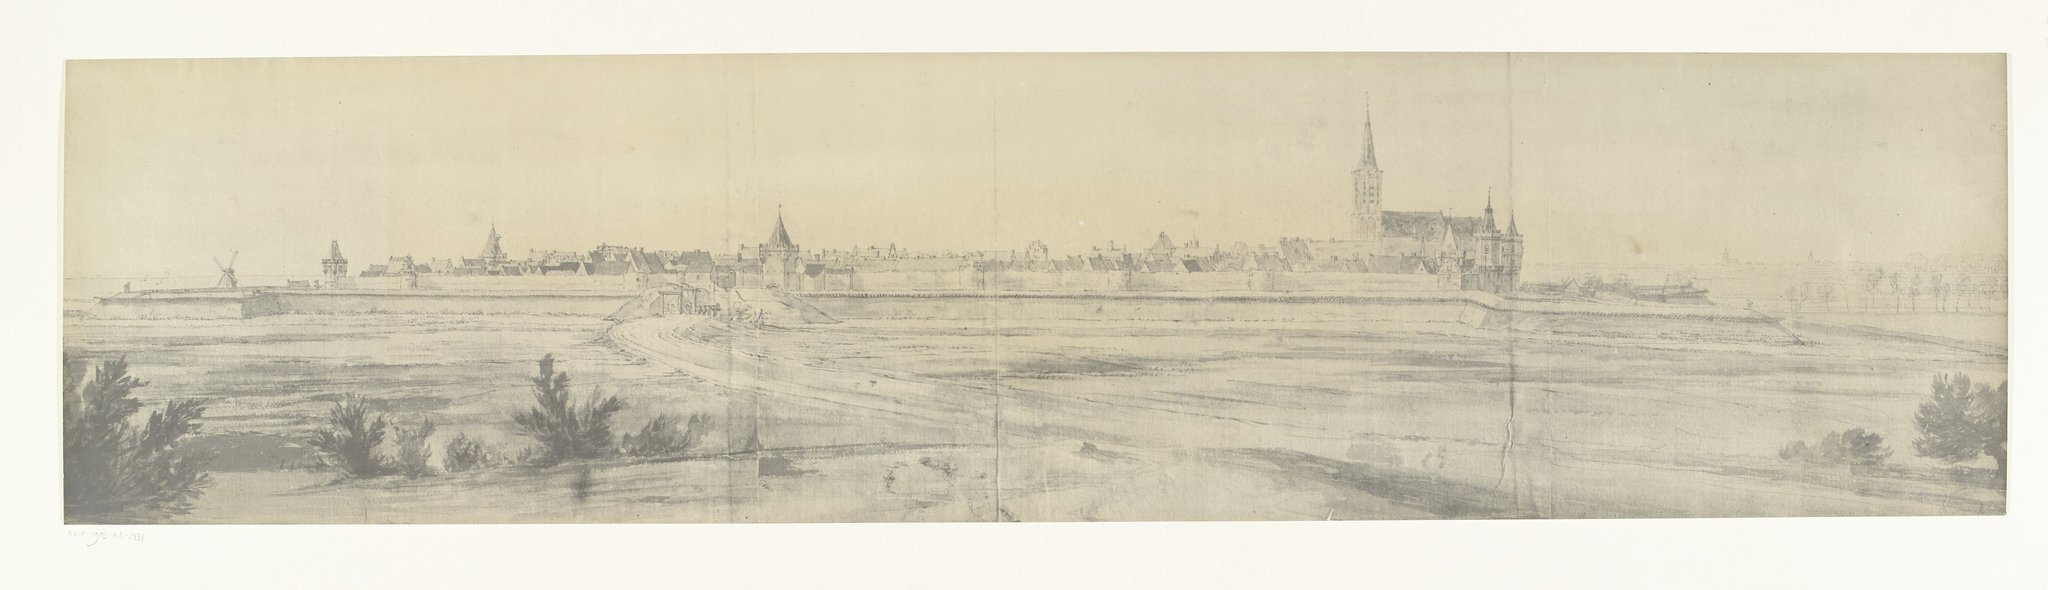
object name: photograph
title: Gezicht op Elburg, 1672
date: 1900-1903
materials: paper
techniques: gelatin silver print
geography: france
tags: lodewijk xiv (koning van frankrijk), city-view, and landscape with man-made constructions, rampjaar (disaster year)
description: Niet in Frederik Muller; door het RPK toegevoegd nummer. Onderdeel van een groep van ca. 50 foto's van tekeningen van de Franse inval in de Nederlanden in 1672 door Adam Frans van der Meulen, bewaard in de Manufacture Nationale des Gobelins te Parijs.